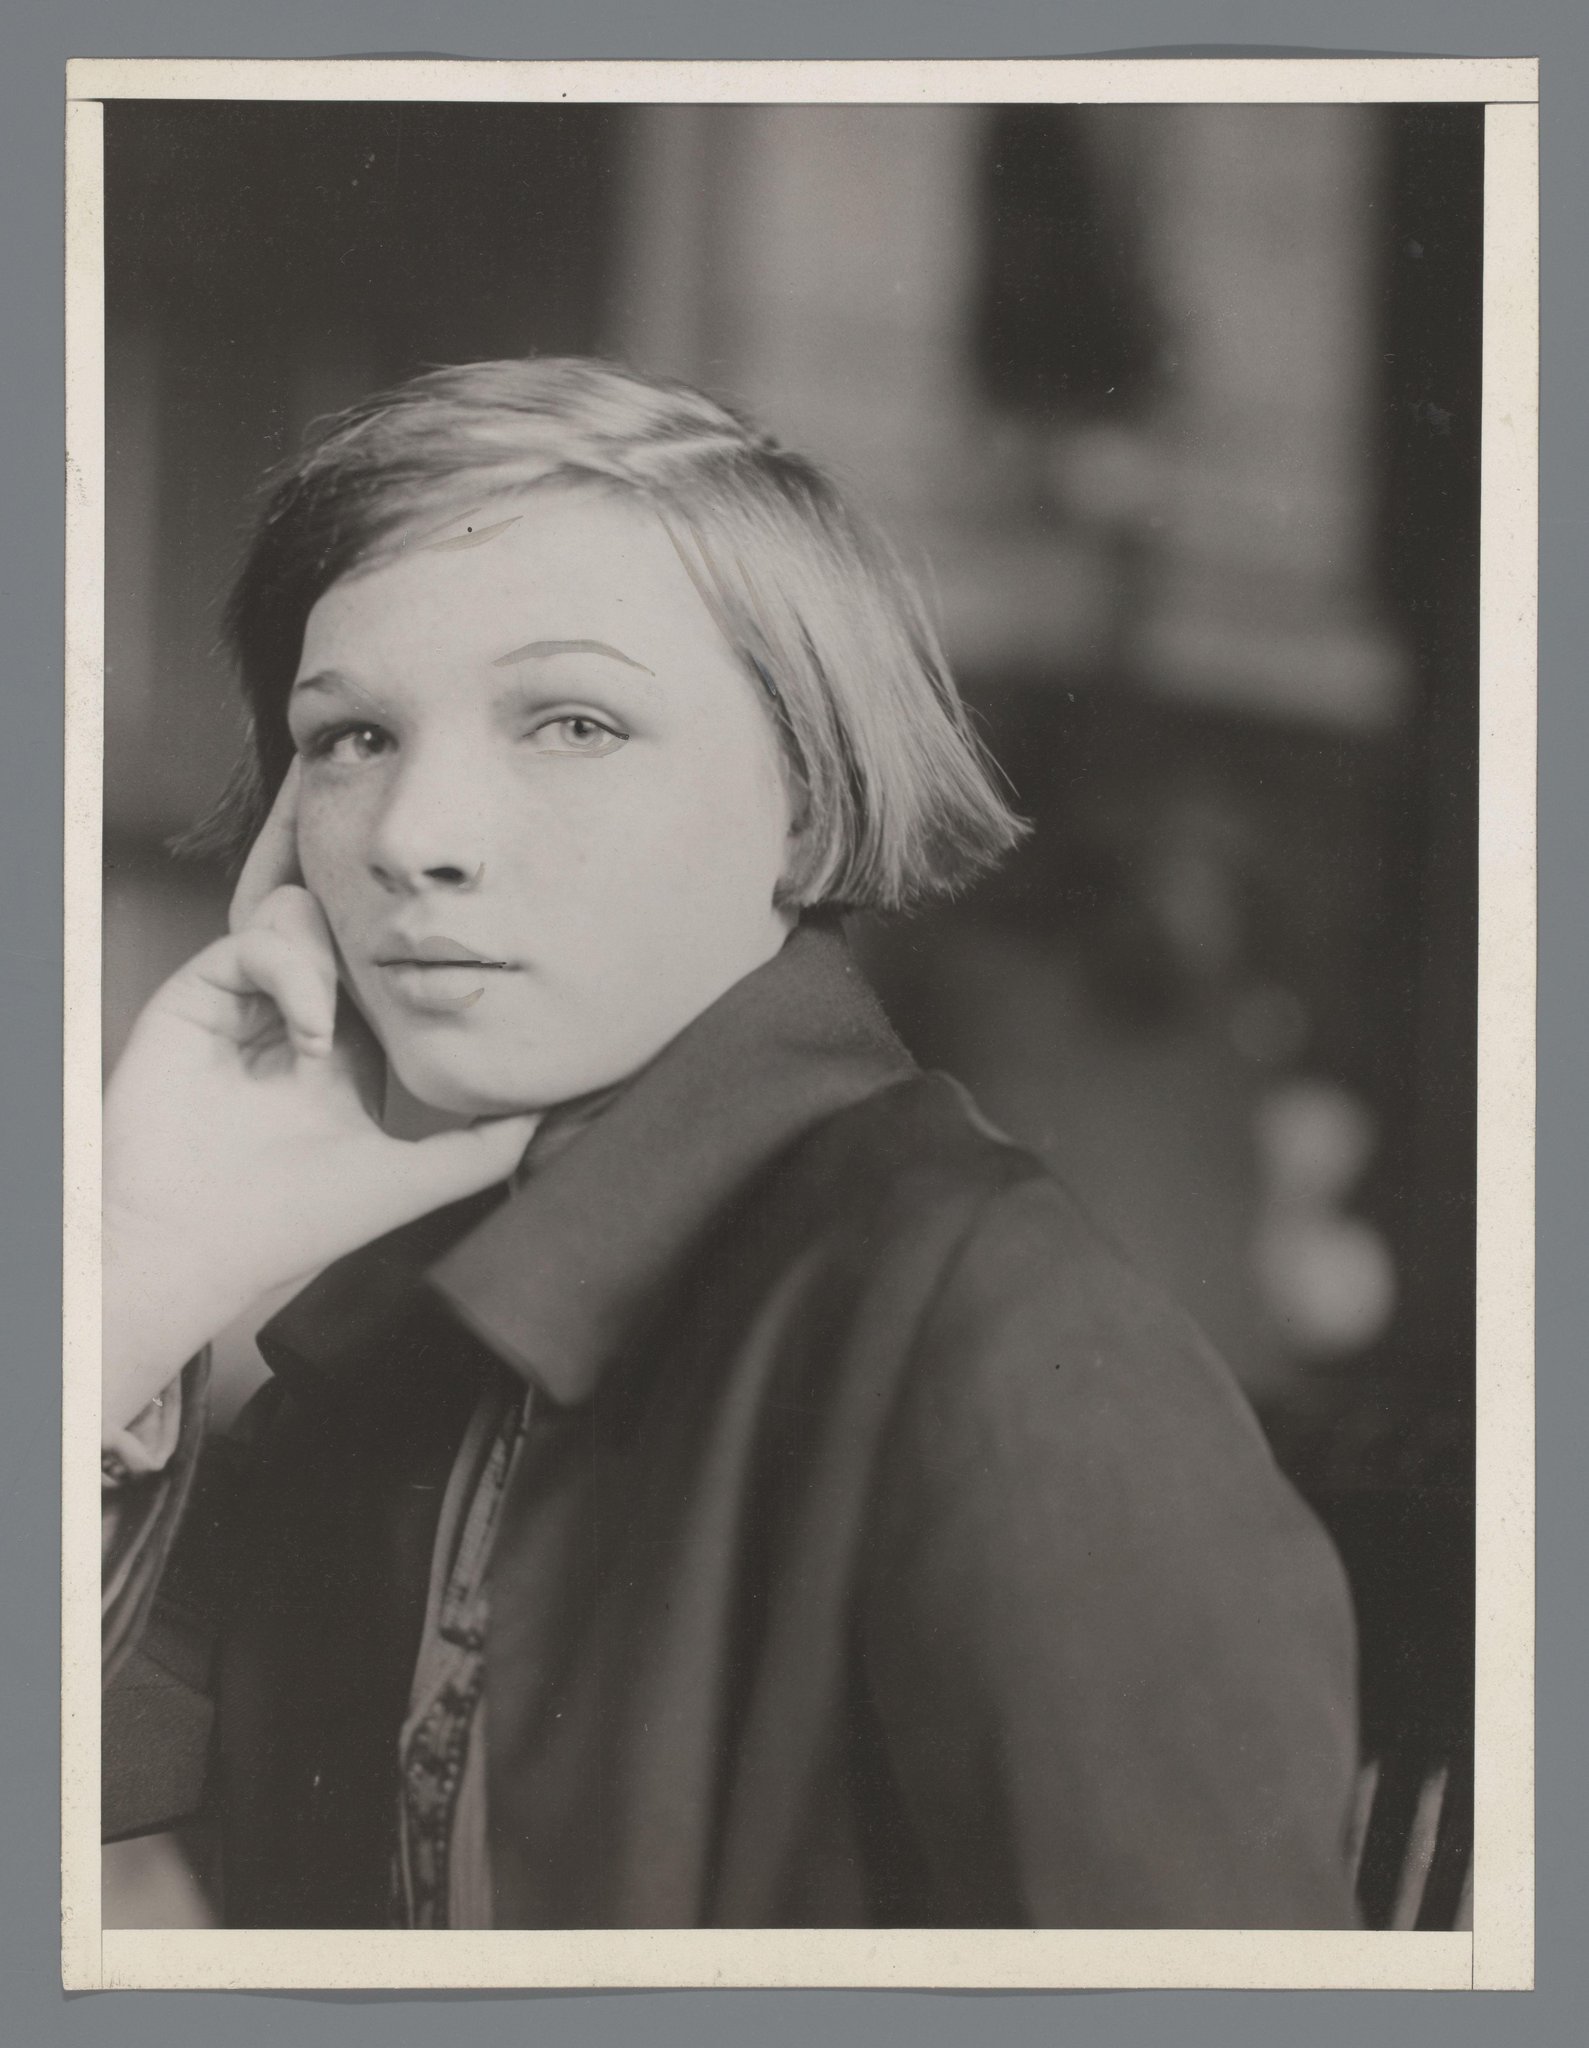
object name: photograph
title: Portret van Dorothy Perkins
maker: Anonymous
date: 1926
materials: paper, photographic support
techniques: gelatin silver print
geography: united states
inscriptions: annotation: ‘17 5434’, annotation: ‘Dorothy Perkins Killed the Templeton’, stamp: ‘REFERENCE DEPT. JUL 22 1926 N.E.A.’, annotation: ‘Young Killer 1928 Vintage SG c. 1928 £ 350 guilty’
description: Dorothy Perkins, 17 jaar, veroordeeld wegens de moord op Thomas Templeton